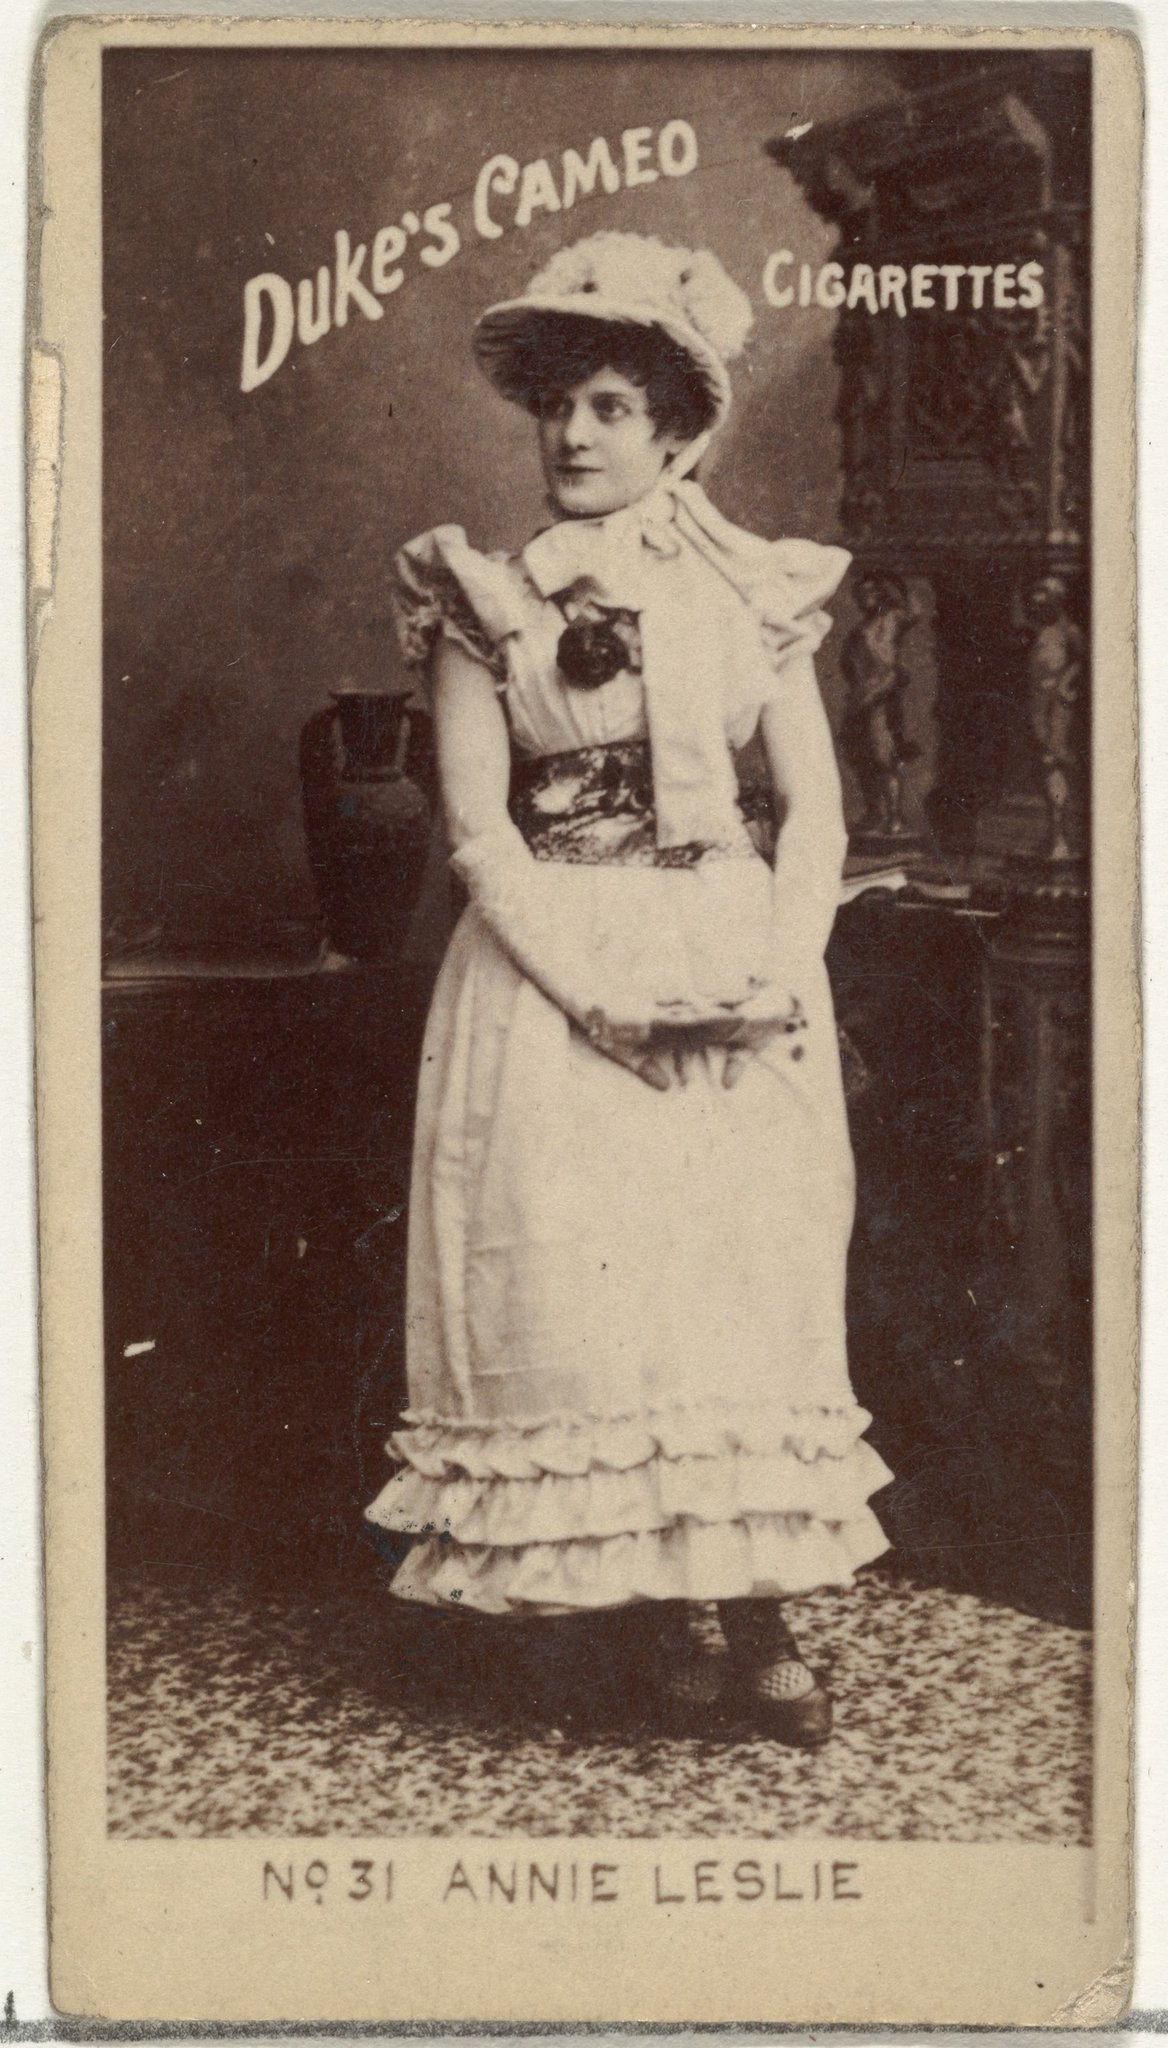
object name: photograph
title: Card Number 31, Annie Leslie, from the Actors and Actresses series (N145-4) issued by Duke Sons & Co. to promote Cameo Cigarettes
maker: w. duke, sons & co.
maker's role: publisher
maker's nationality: american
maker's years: 1870-1920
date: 1880-1889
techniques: albumen silver print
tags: portraits,women,actresses